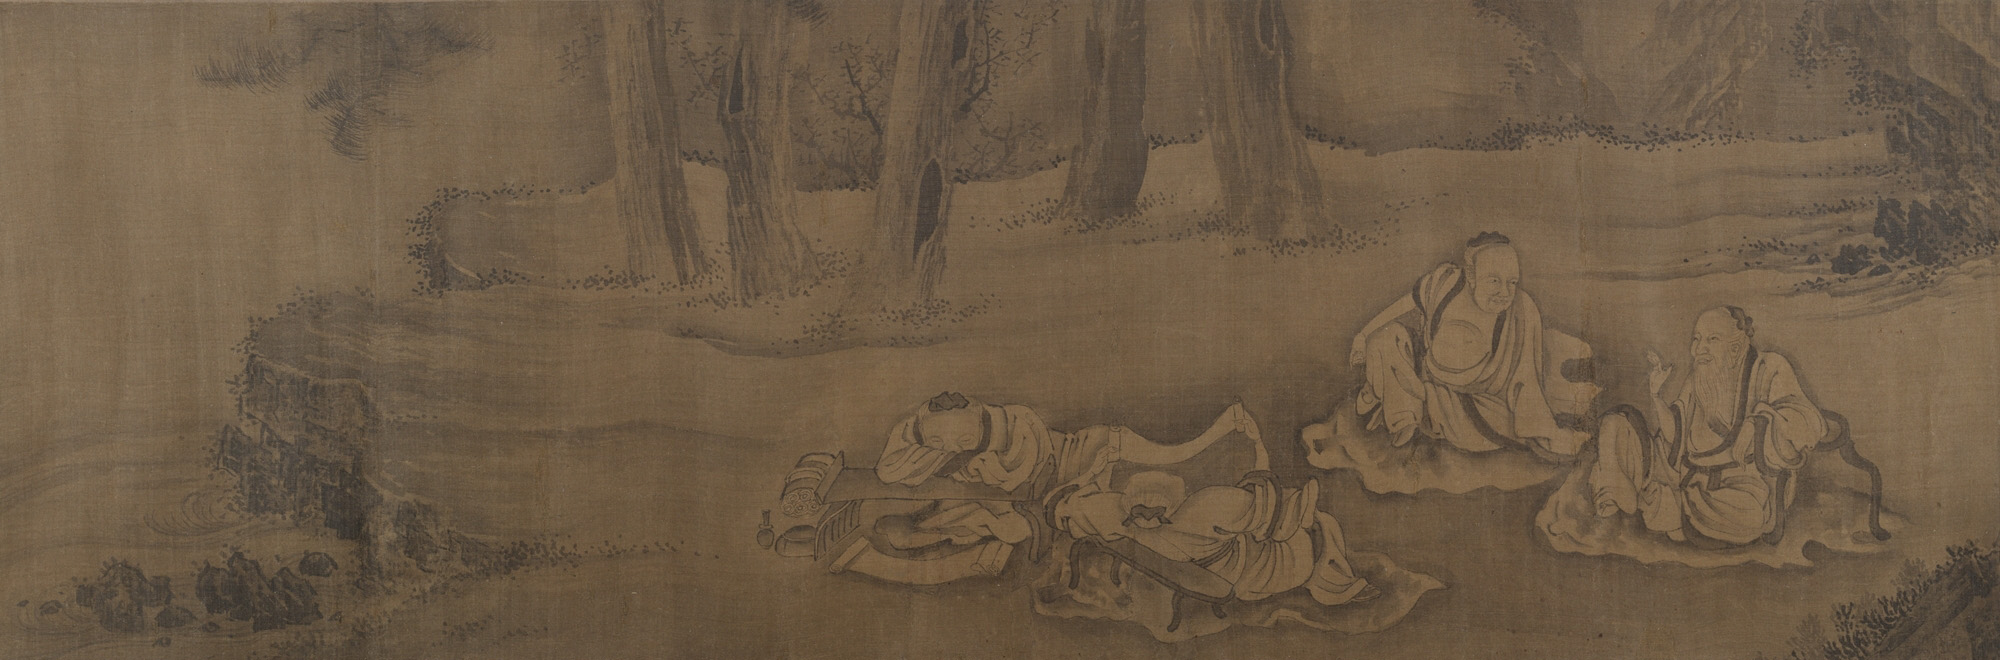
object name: handscroll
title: Scholars and Monkeys under Trees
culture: chinese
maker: unidentified artist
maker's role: artist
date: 1368-1911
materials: ink, silk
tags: men,monkeys,trees